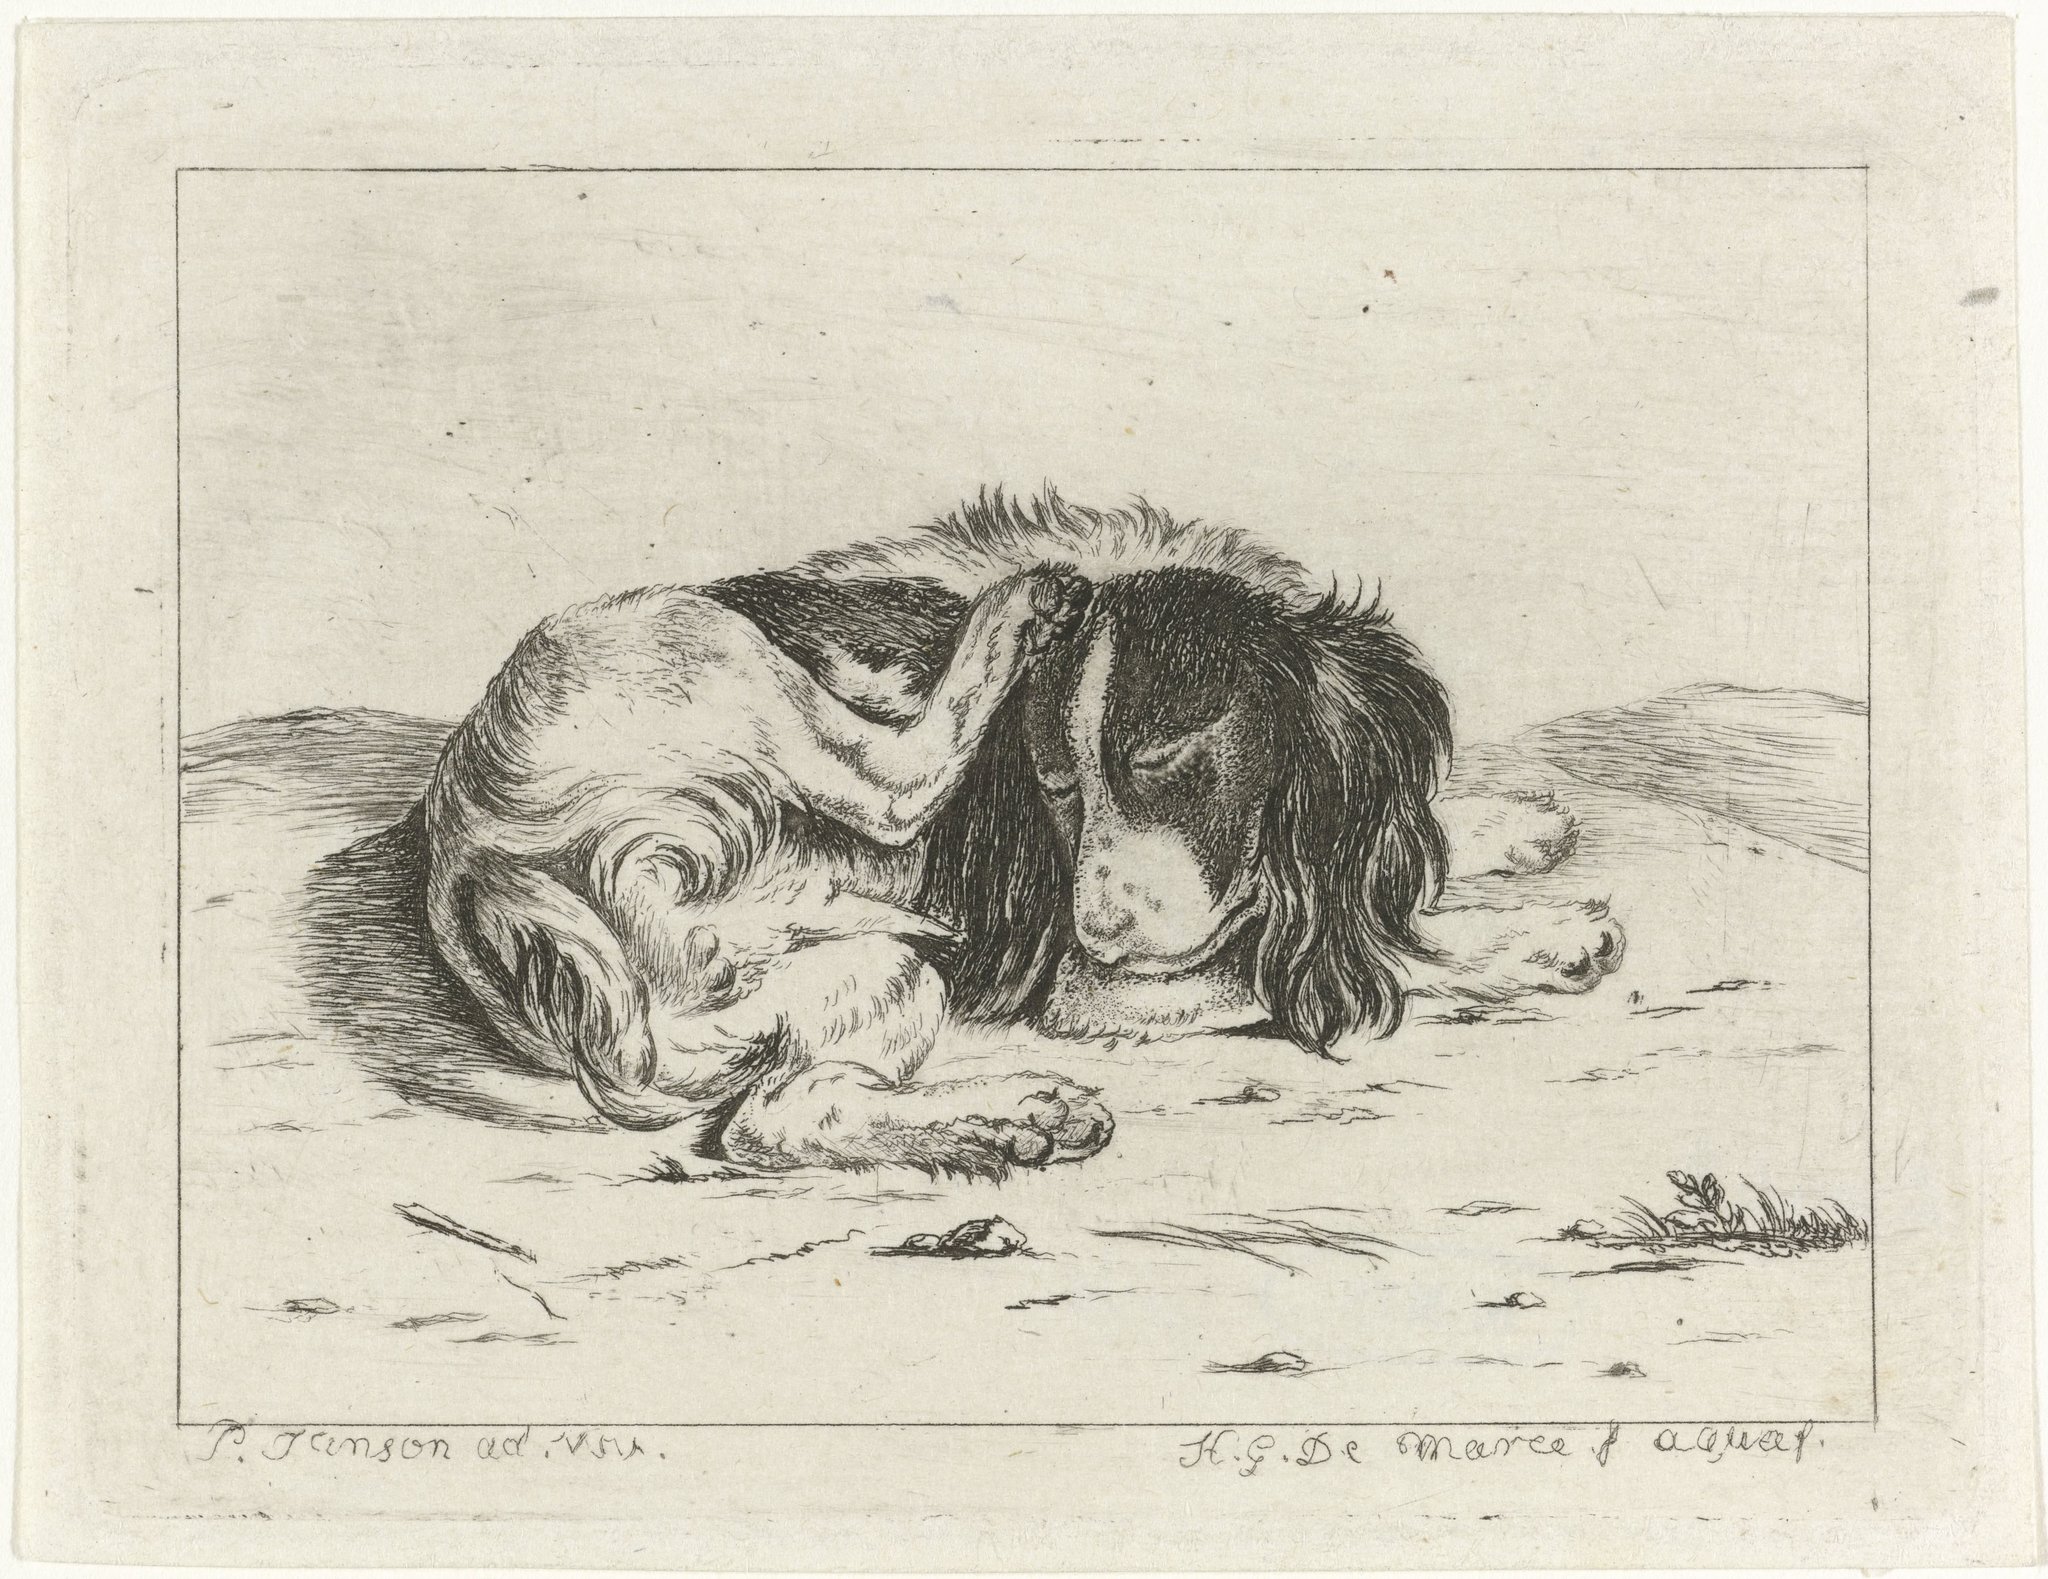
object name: print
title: Slapende hond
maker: pieter janson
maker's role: draughtsman, print maker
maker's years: 1765-1851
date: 1752-1783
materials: paper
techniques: etching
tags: dog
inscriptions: collector's mark: Lugt 2228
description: Samen met A 590 tot en met A 592, Inv. Teek. v.B. 73